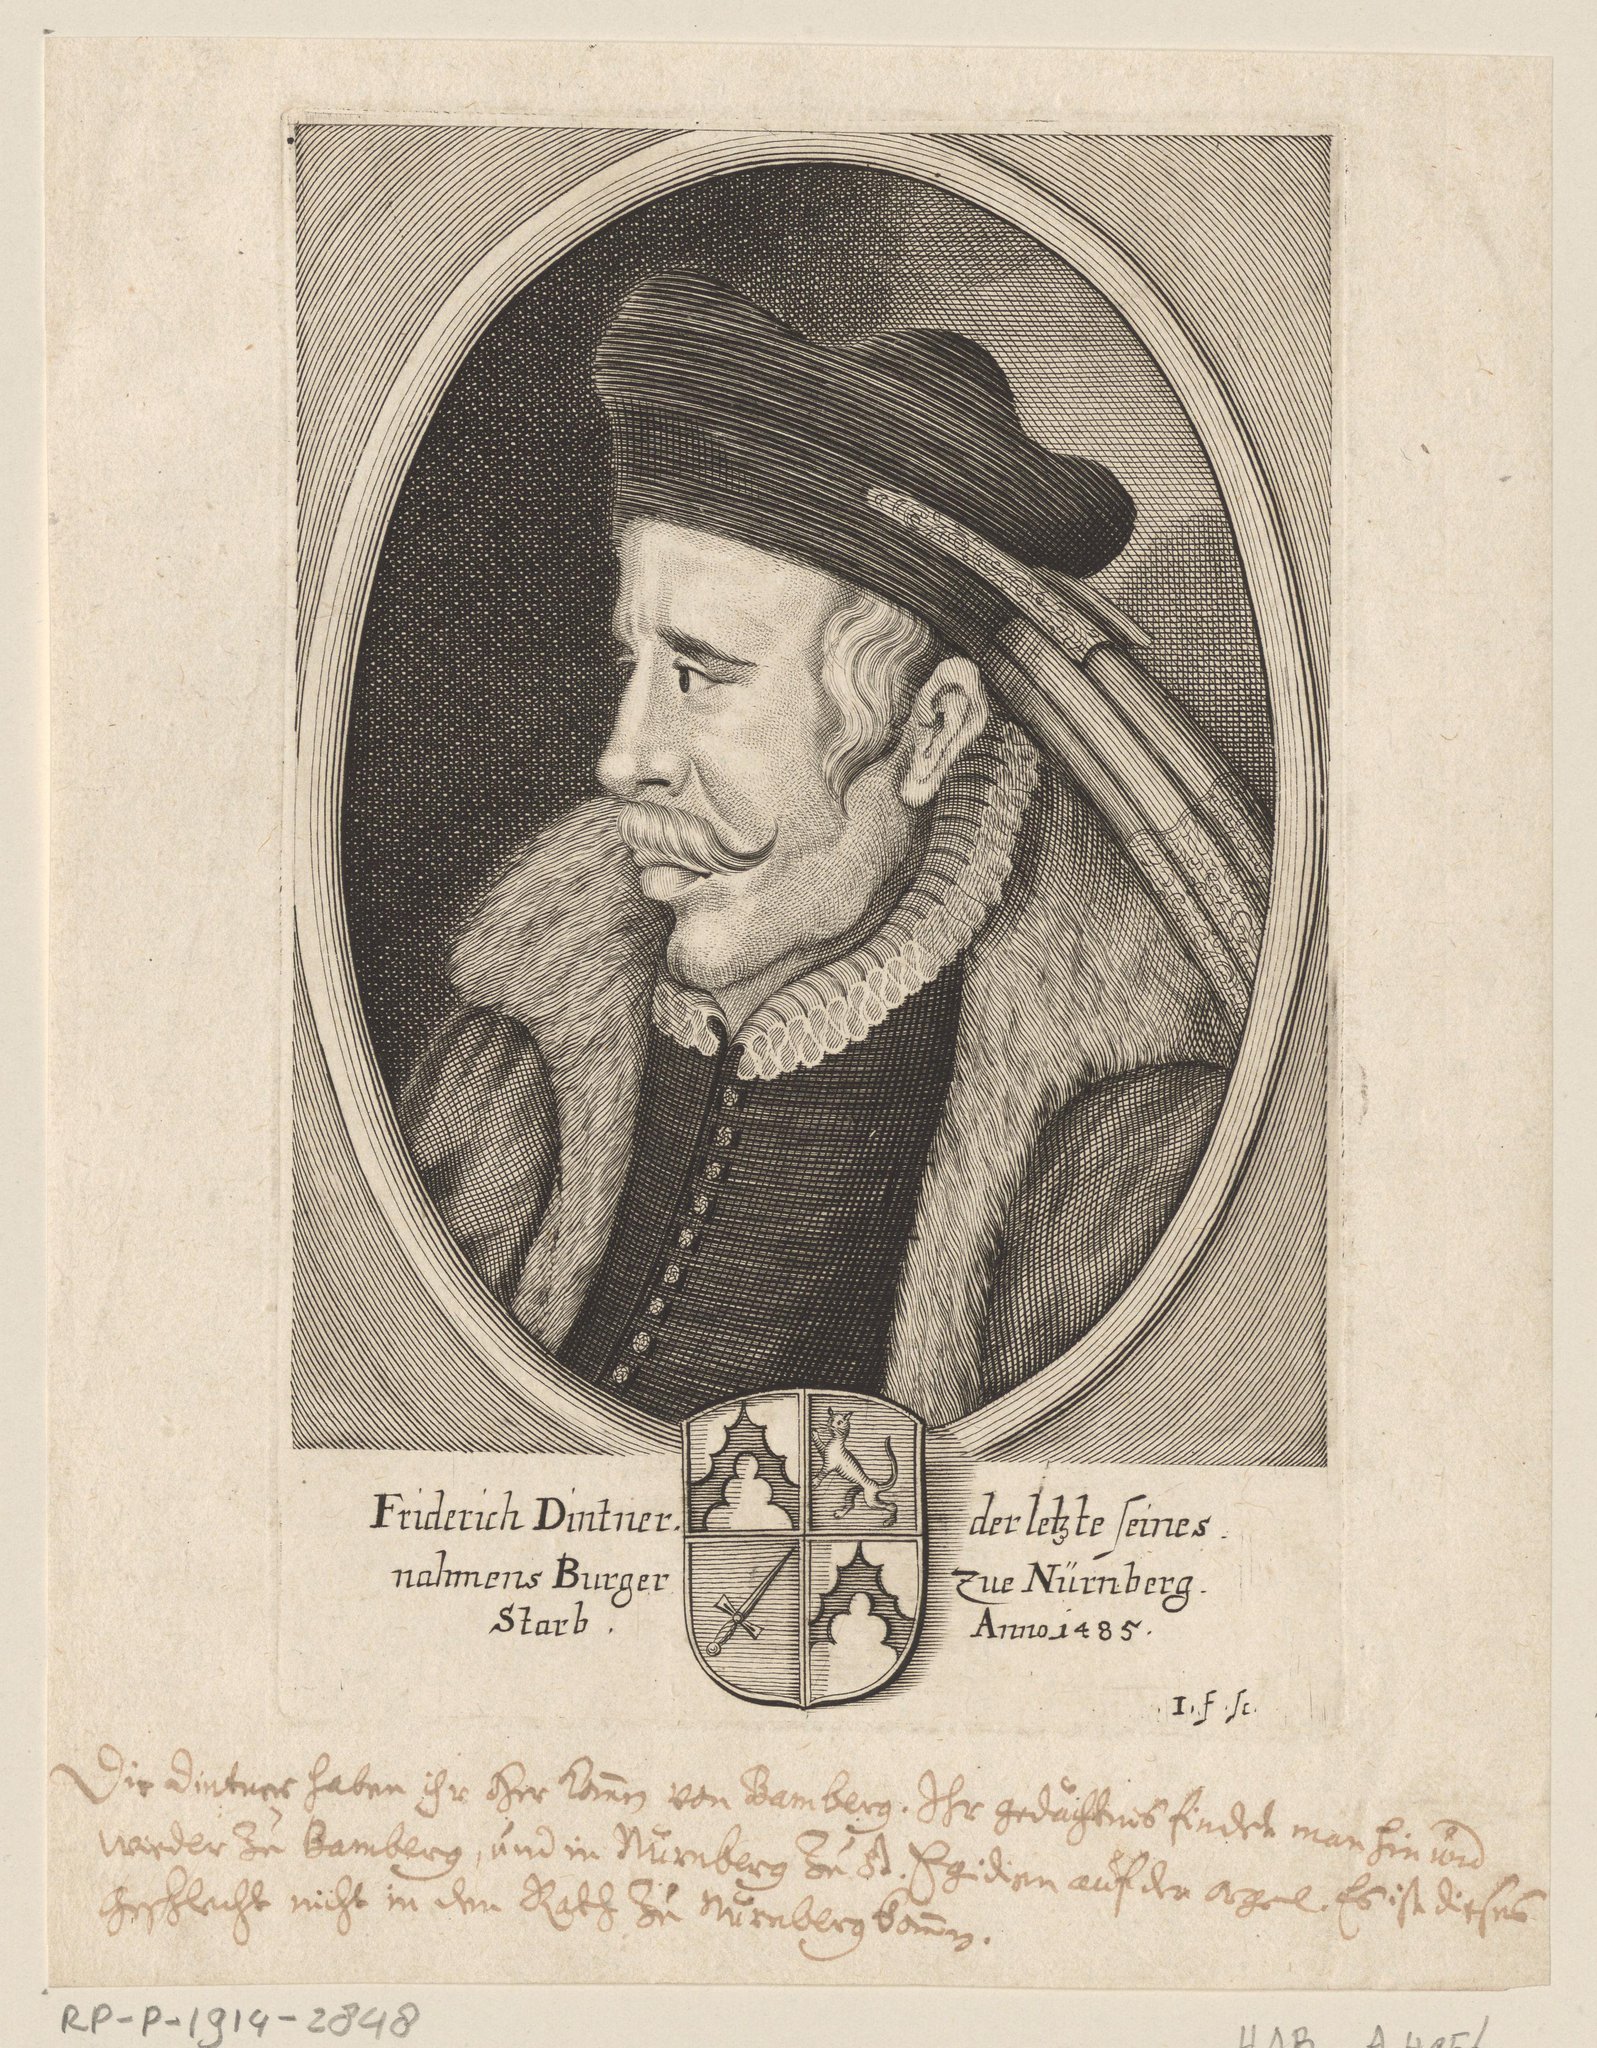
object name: print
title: Portret van Friedrich Dintner I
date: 1641-1665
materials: paper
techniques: engraving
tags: historical persons, armorial bearing, heraldry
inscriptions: collector's mark: Lugt 2228